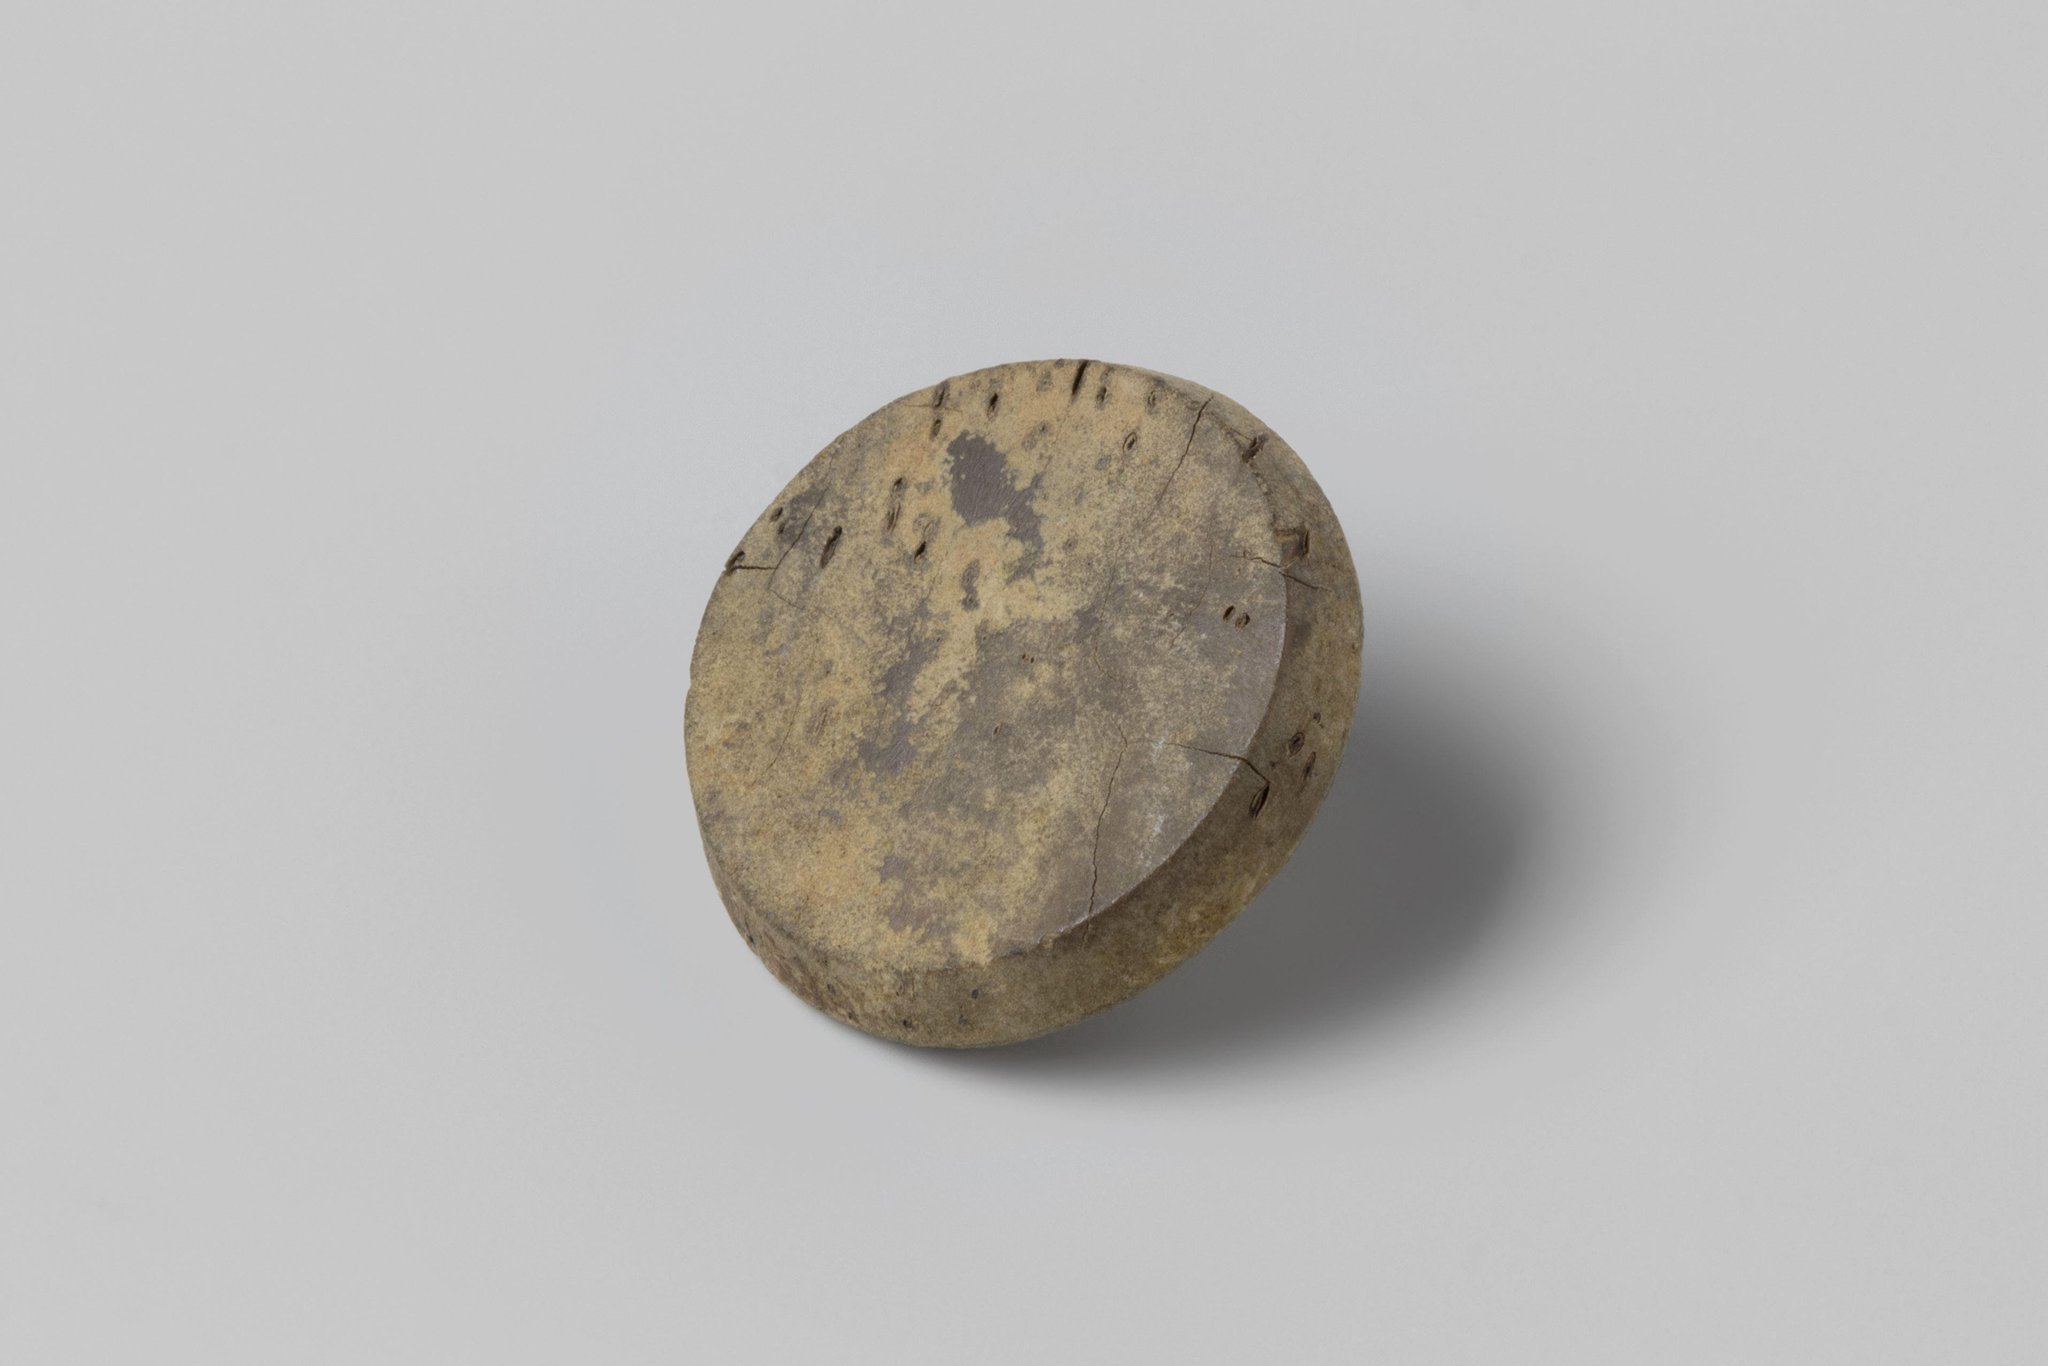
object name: button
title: Knoop uit het wrak van de Oost-Indiëvaarder Hollandia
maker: Anonymous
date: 1700-1743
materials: bone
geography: netherlands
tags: verenigde oostindische compagnie, hollandia (schip), annet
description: Knoop. (1) flat, bevelled rim, plain (2d, 0.4t)